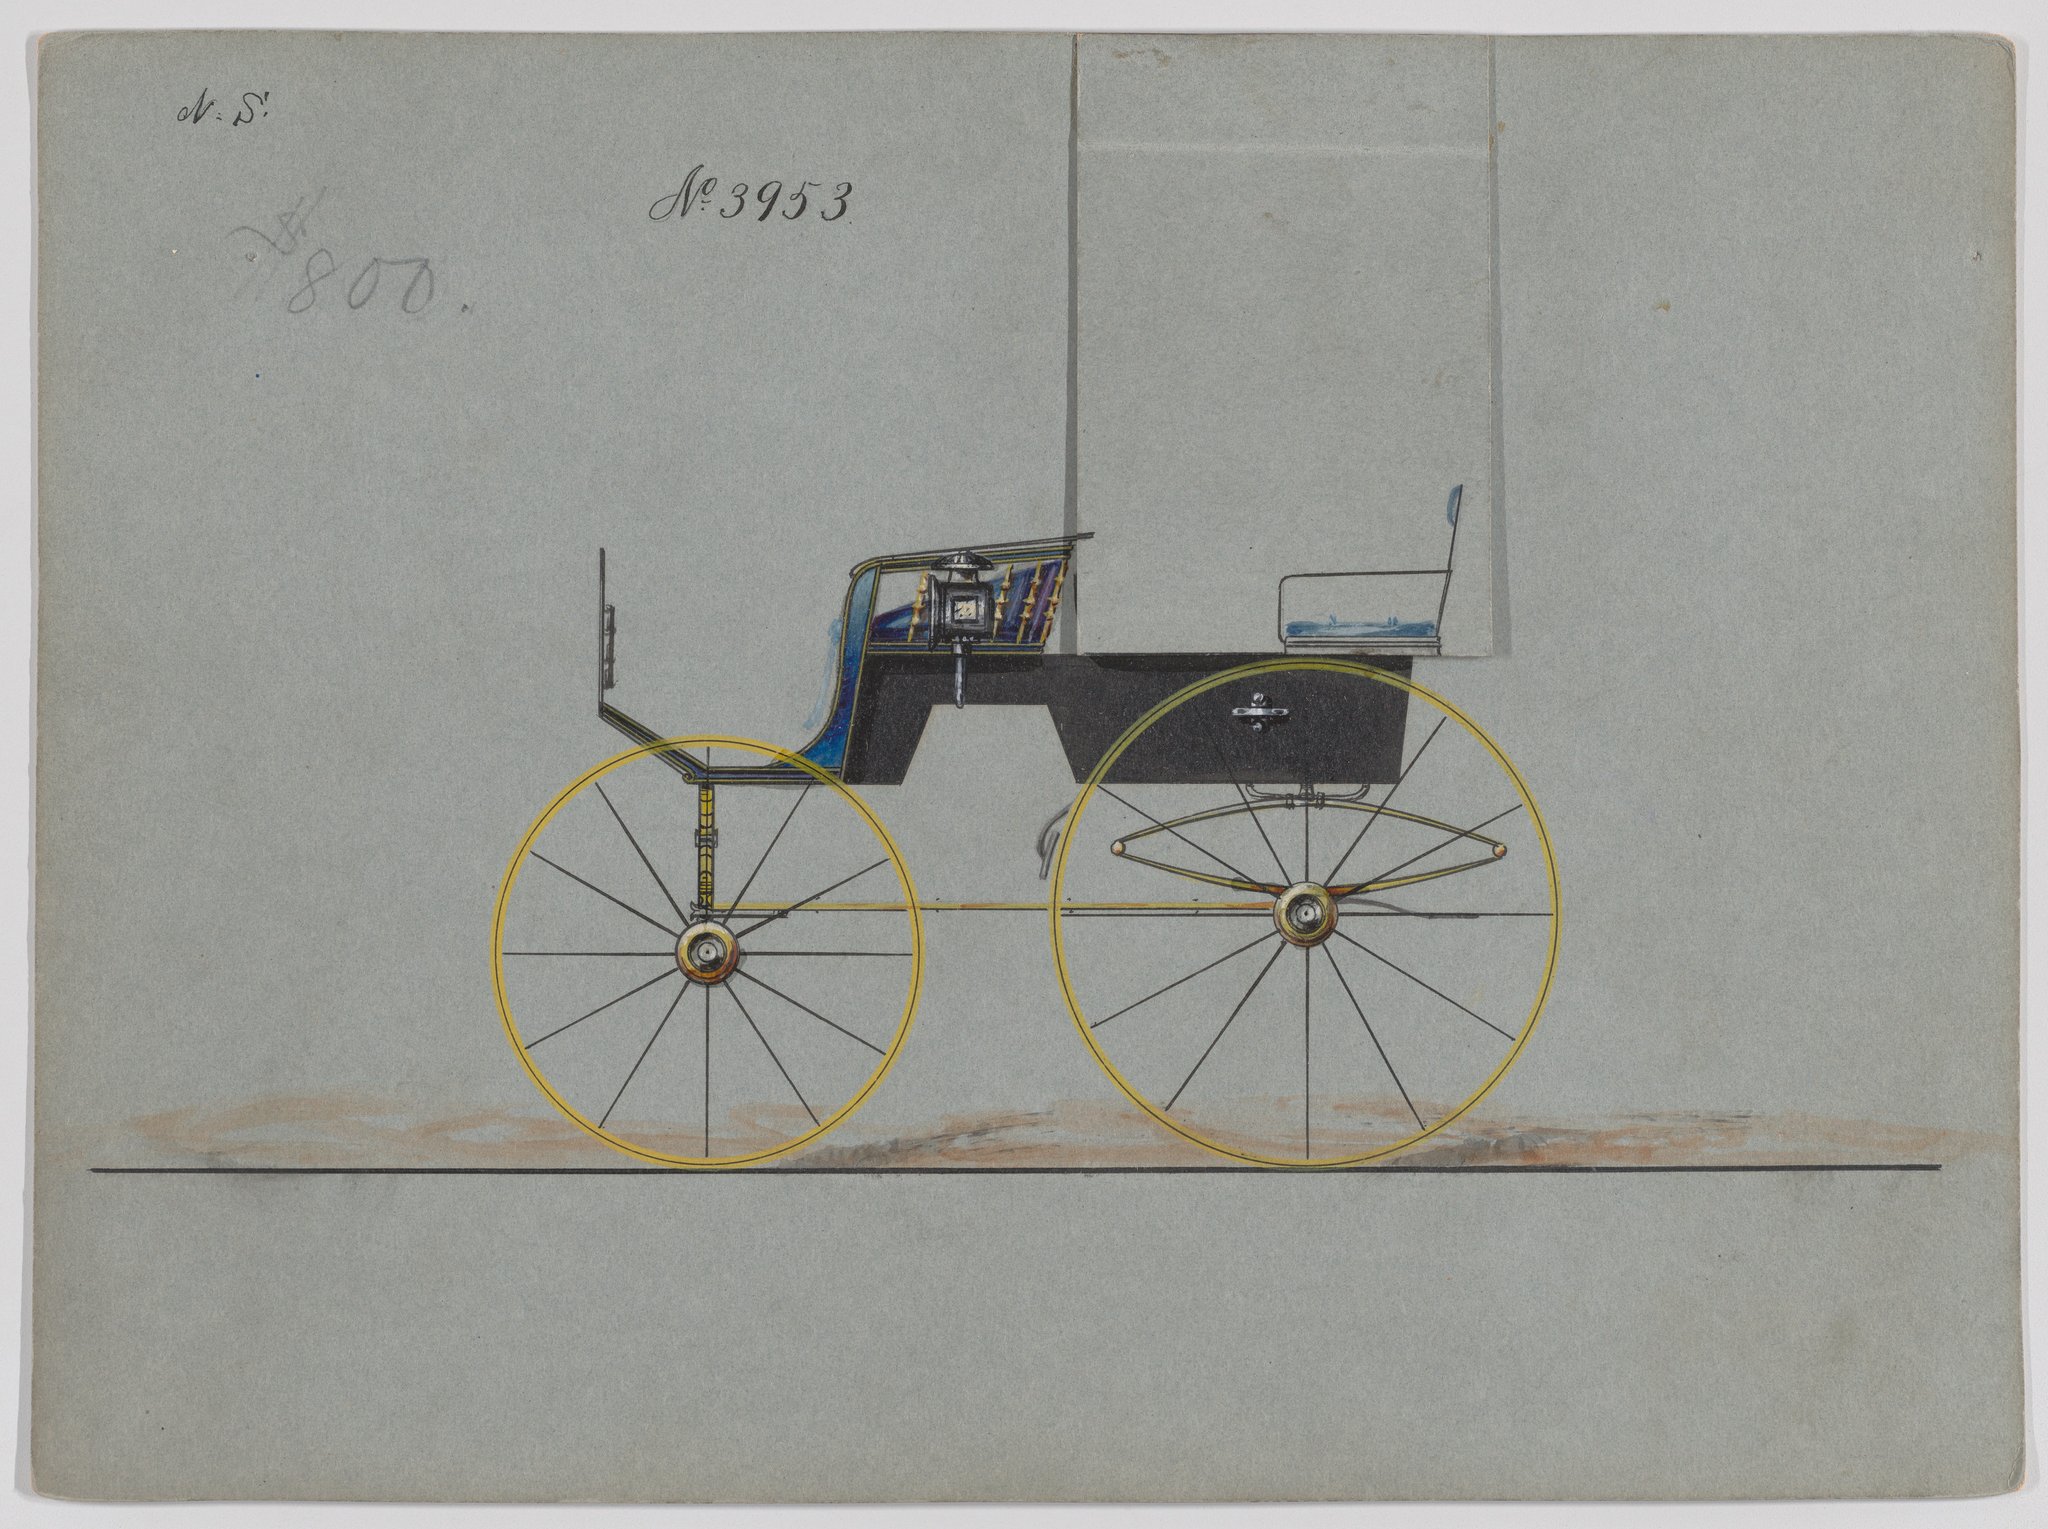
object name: drawing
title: Design for T-Cart, no. 3953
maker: brewster & co.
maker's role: manufacturer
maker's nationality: american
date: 1885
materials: gouache, gum arabic, ink, watercolor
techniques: pen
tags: carriages